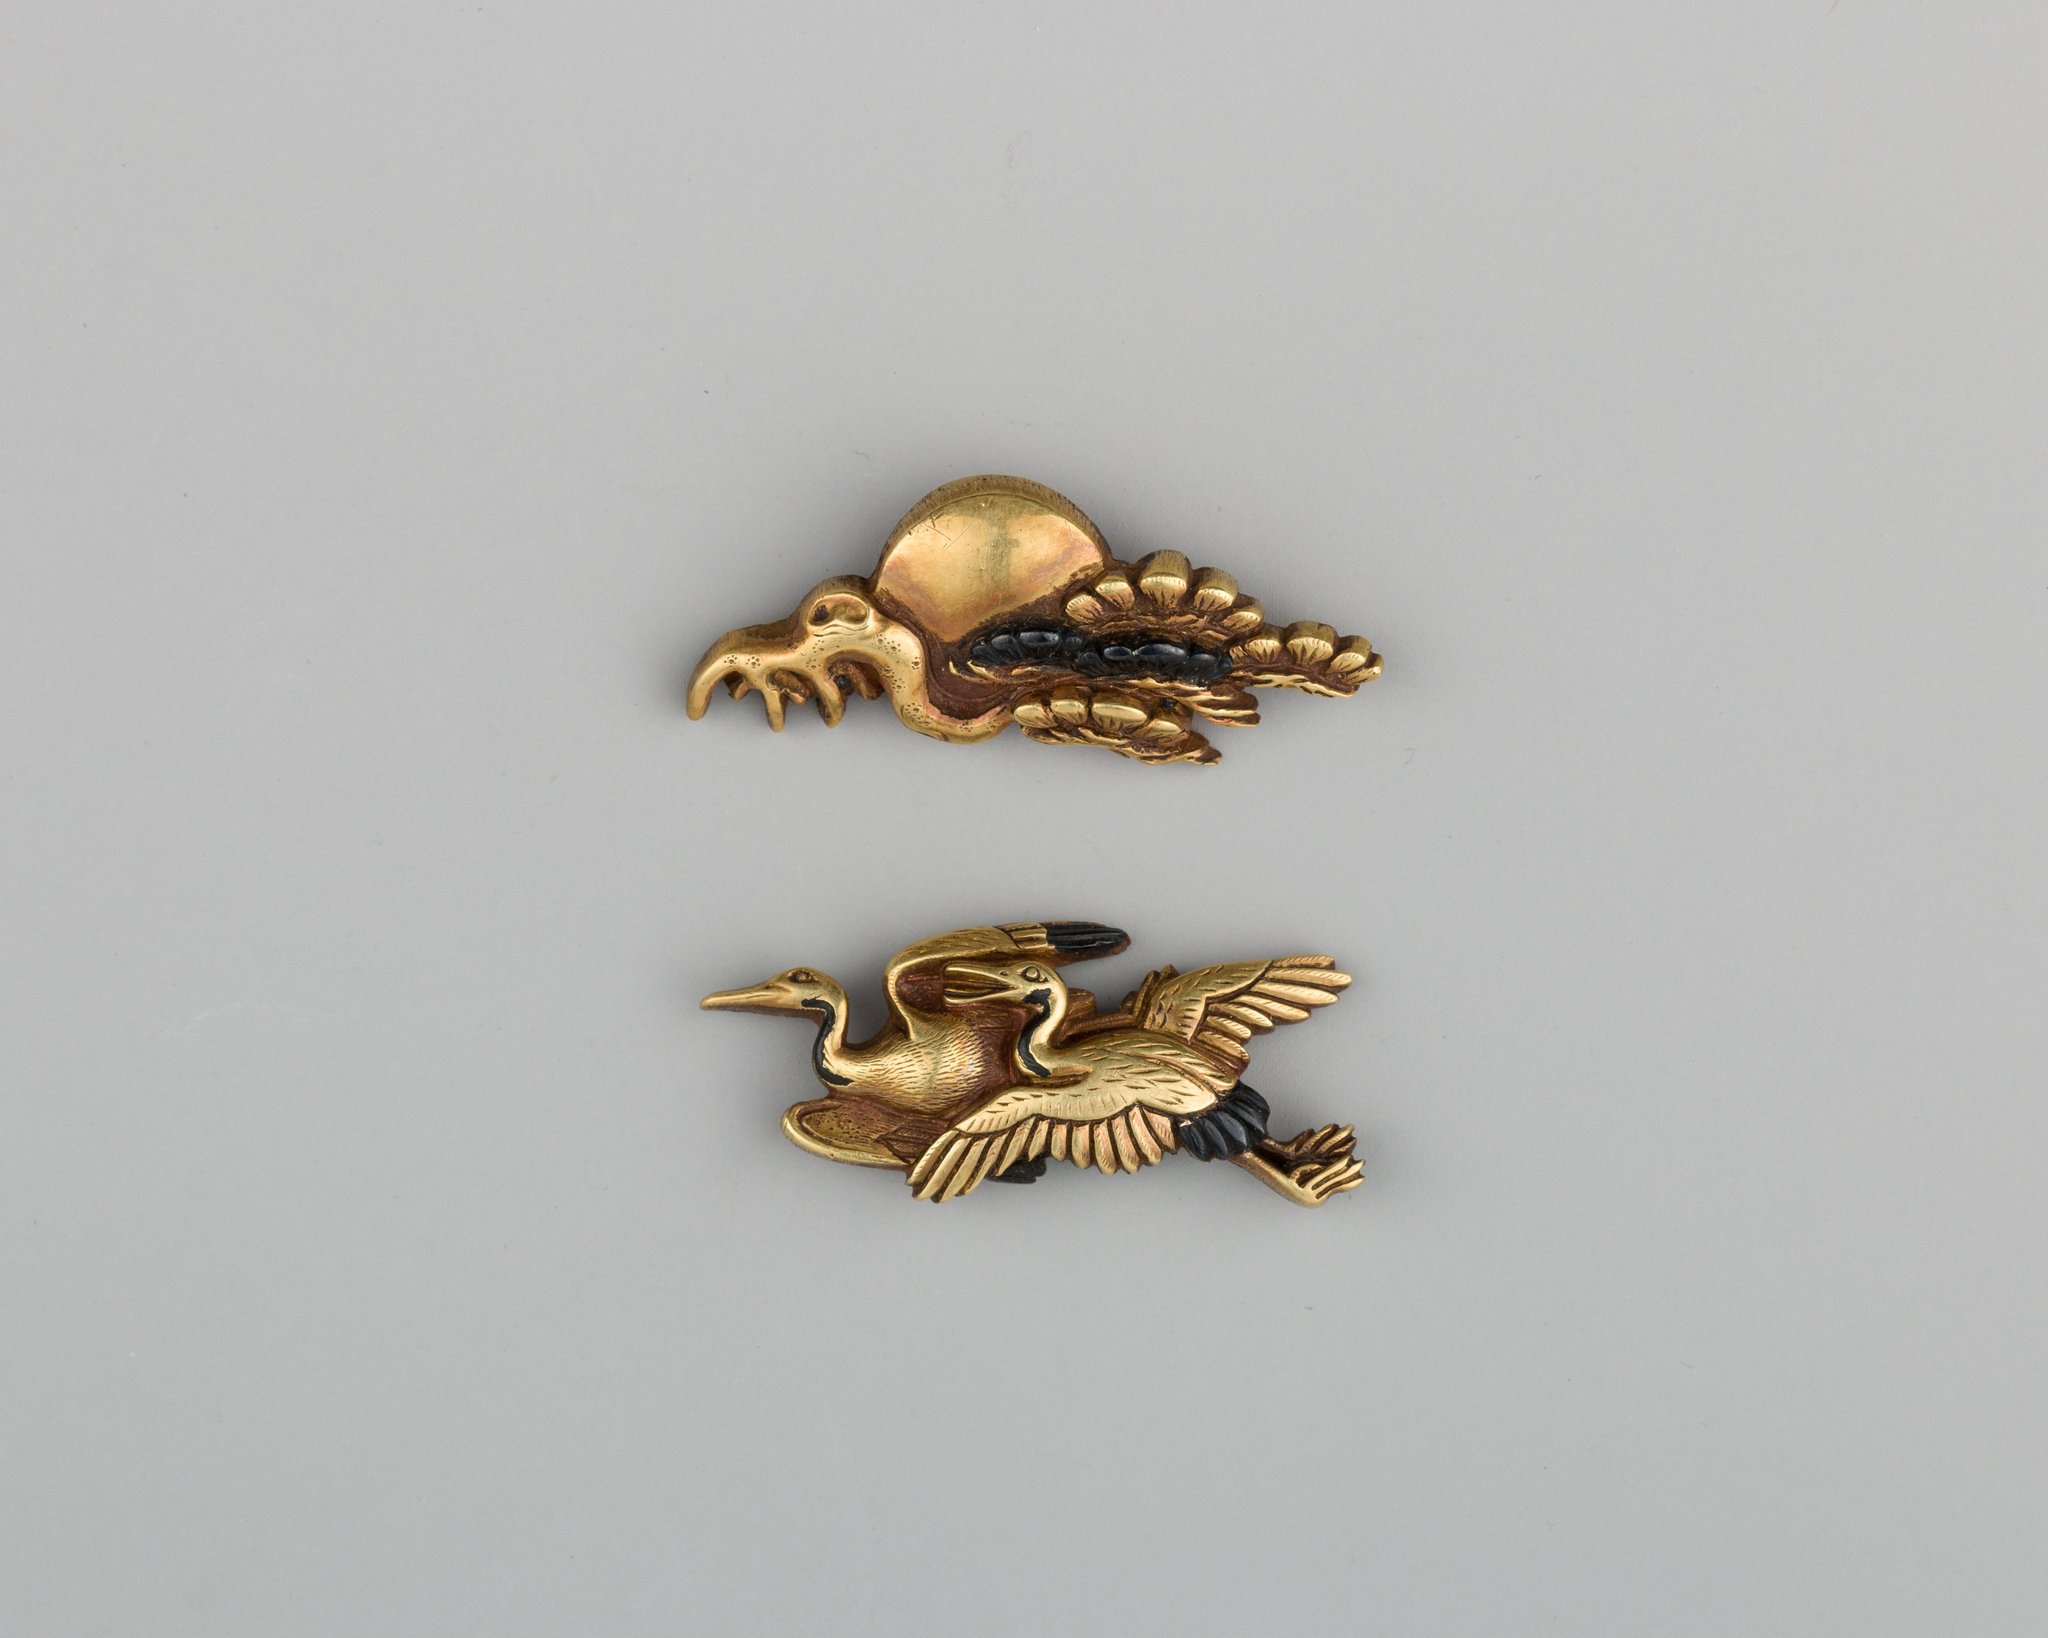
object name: pair of sword grip ornament menuki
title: Pair of Sword-Grip Ornaments (Menuki)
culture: japanese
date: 1701-1800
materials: gold alloy, gold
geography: japan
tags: birds